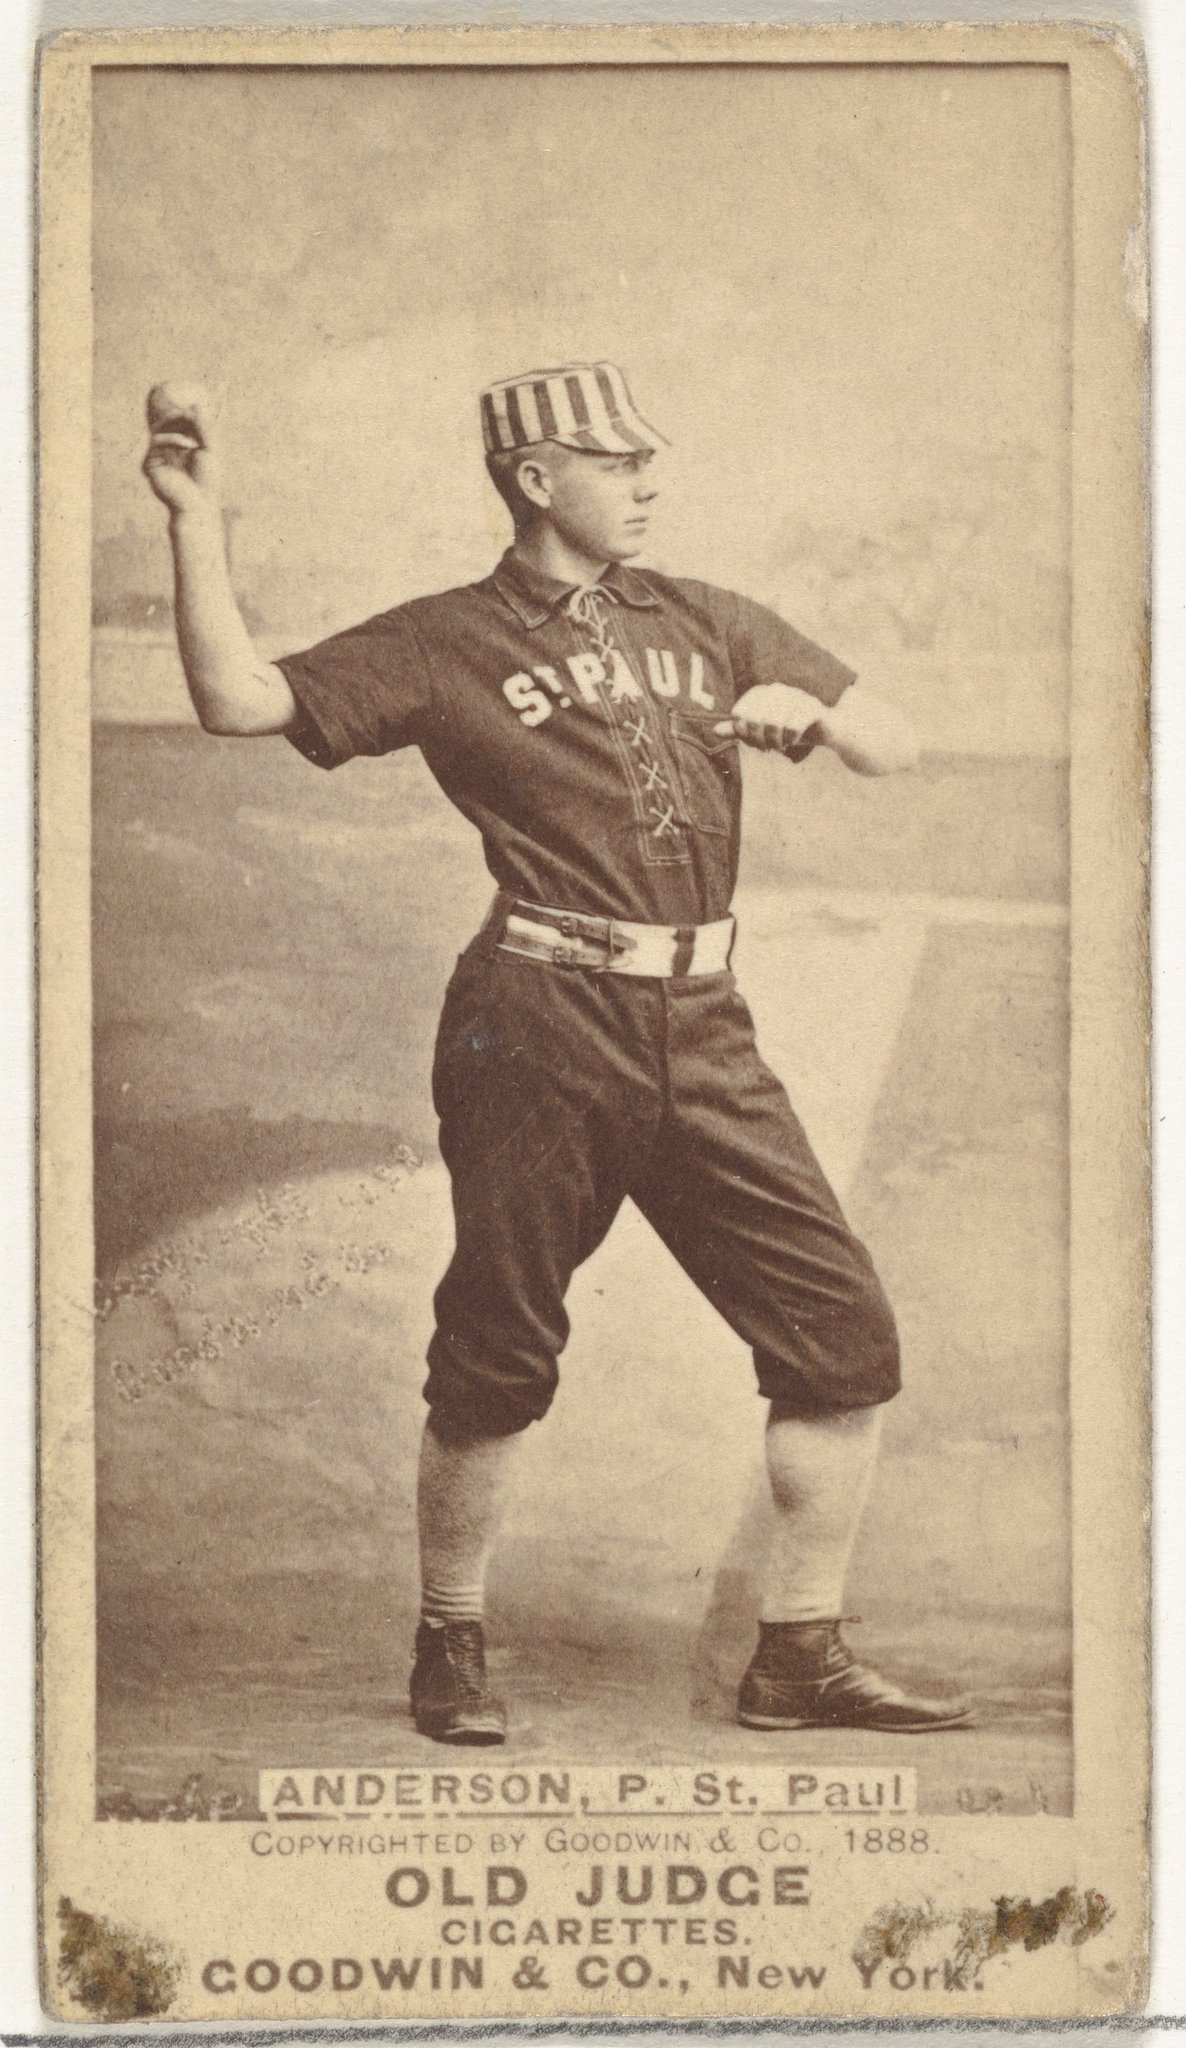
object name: baseball card, photograph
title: Varney Samuel "Varn" Anderson, Pitcher, St. Paul Apostles, from the Old Judge series (N172) for Old Judge Cigarettes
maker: goodwin & company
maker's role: publisher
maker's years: 1850-1950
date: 1888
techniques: albumen silver print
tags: men,portraits,baseball,athletes